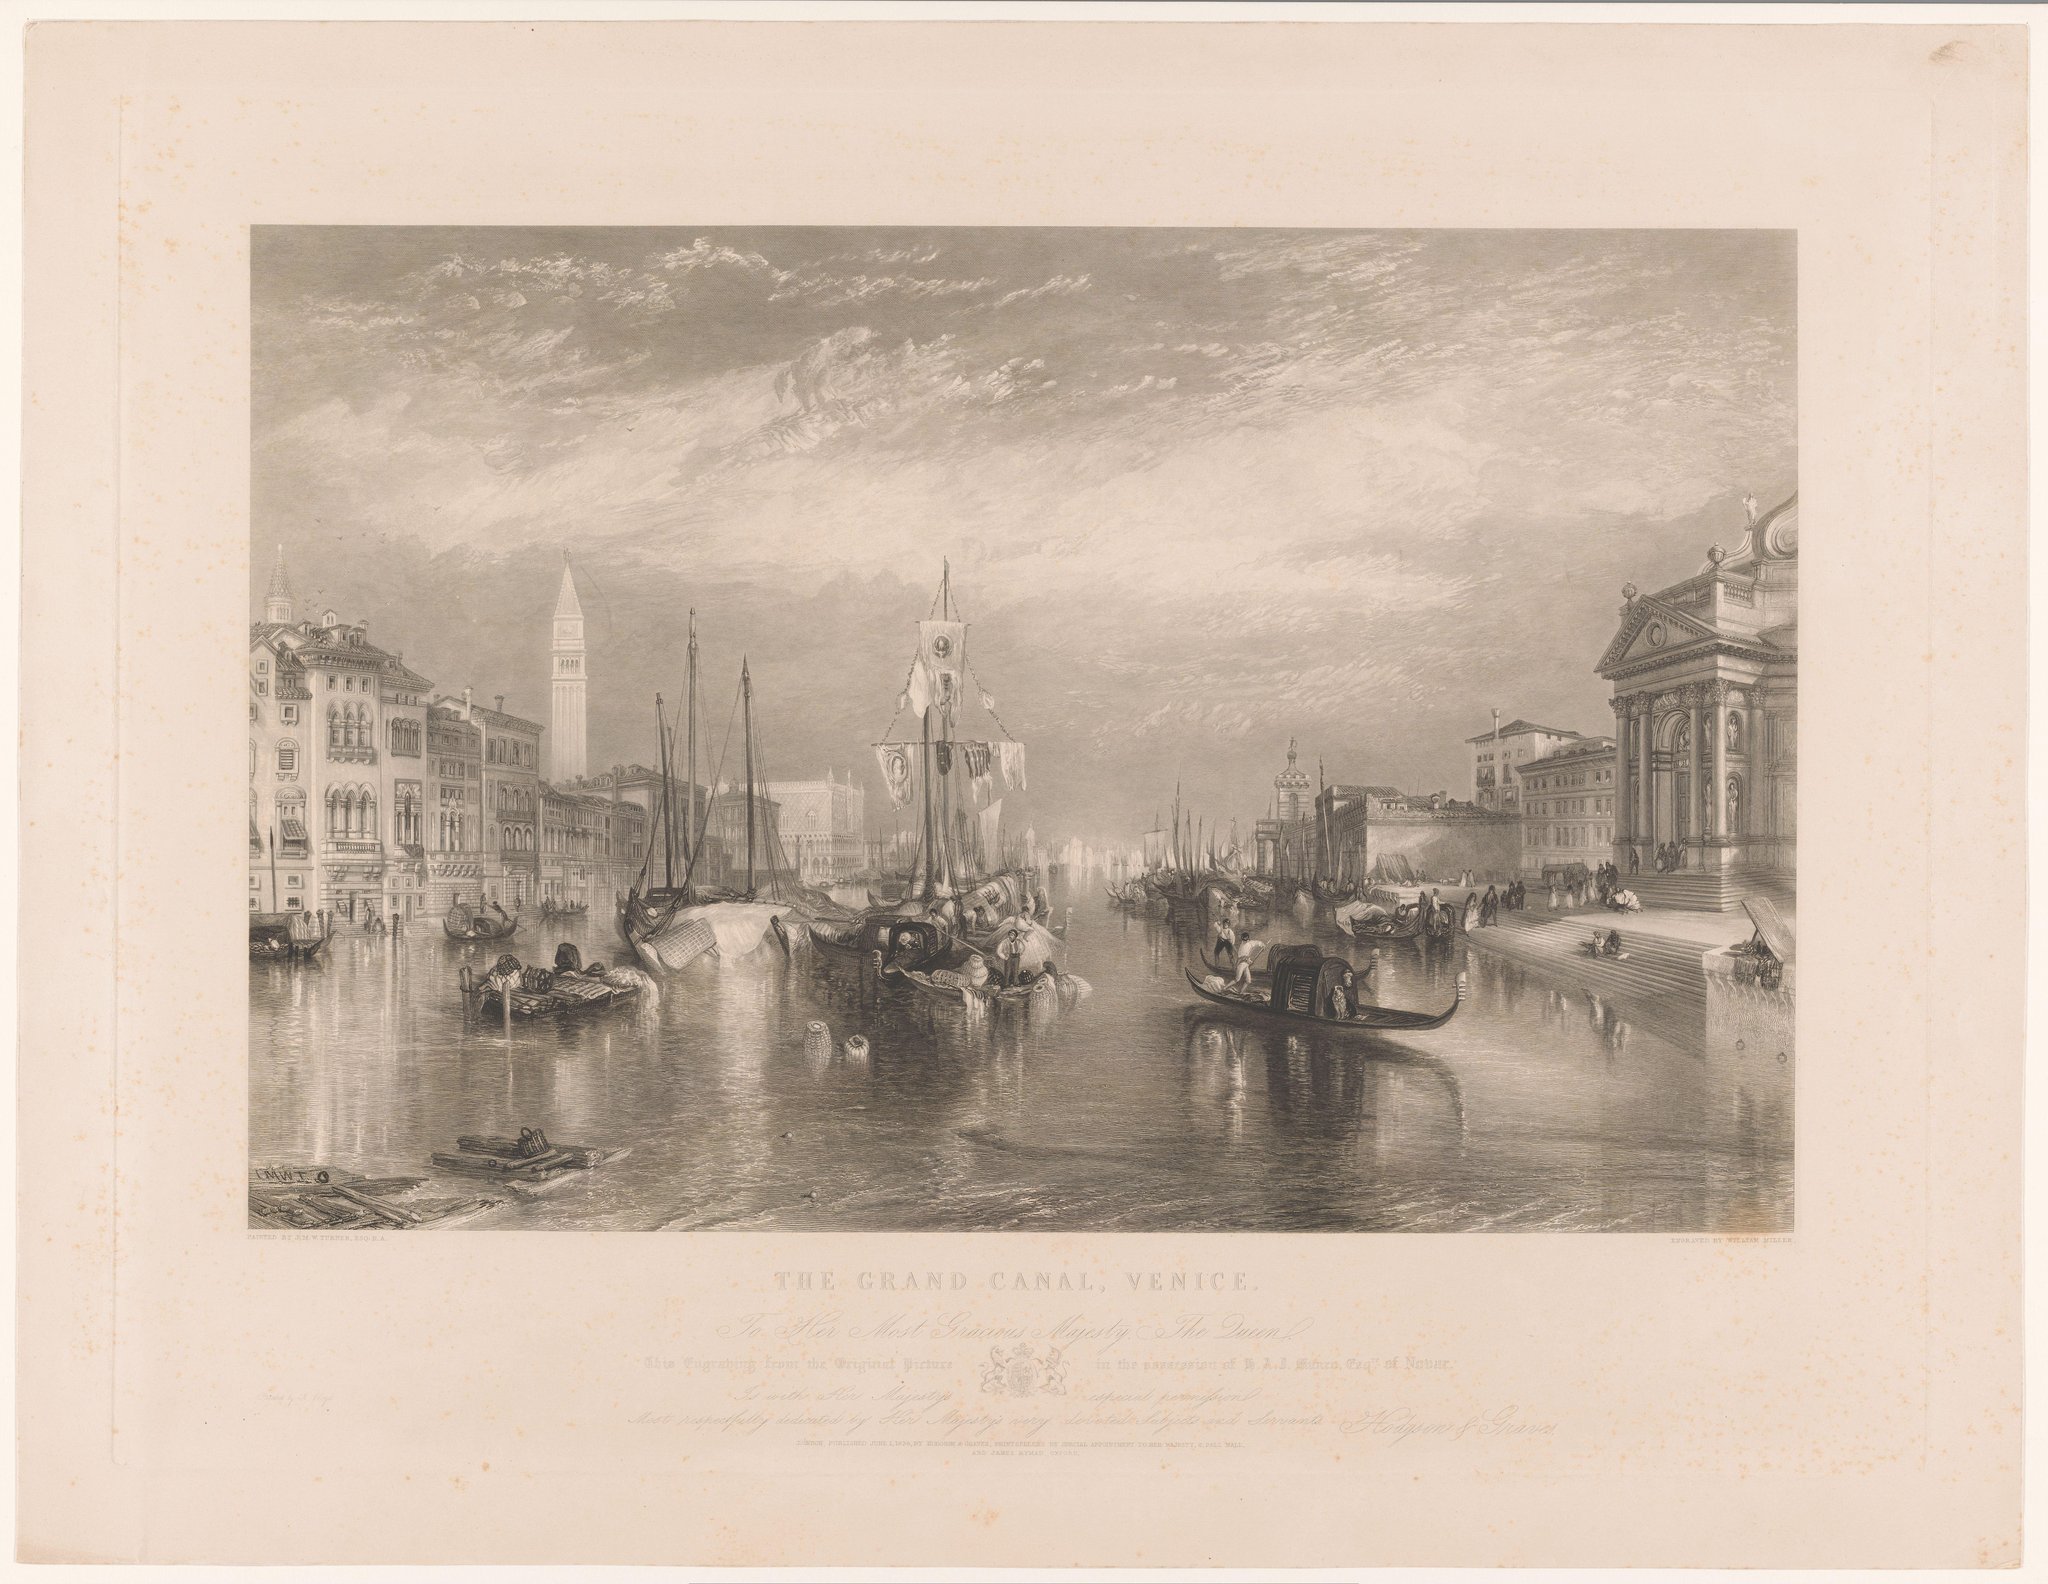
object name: print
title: The Grand Canal, Venice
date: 1838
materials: paper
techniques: engraving, etching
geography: london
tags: canal (+ landscape with figures, staffage)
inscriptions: collector's mark: Lugt 12